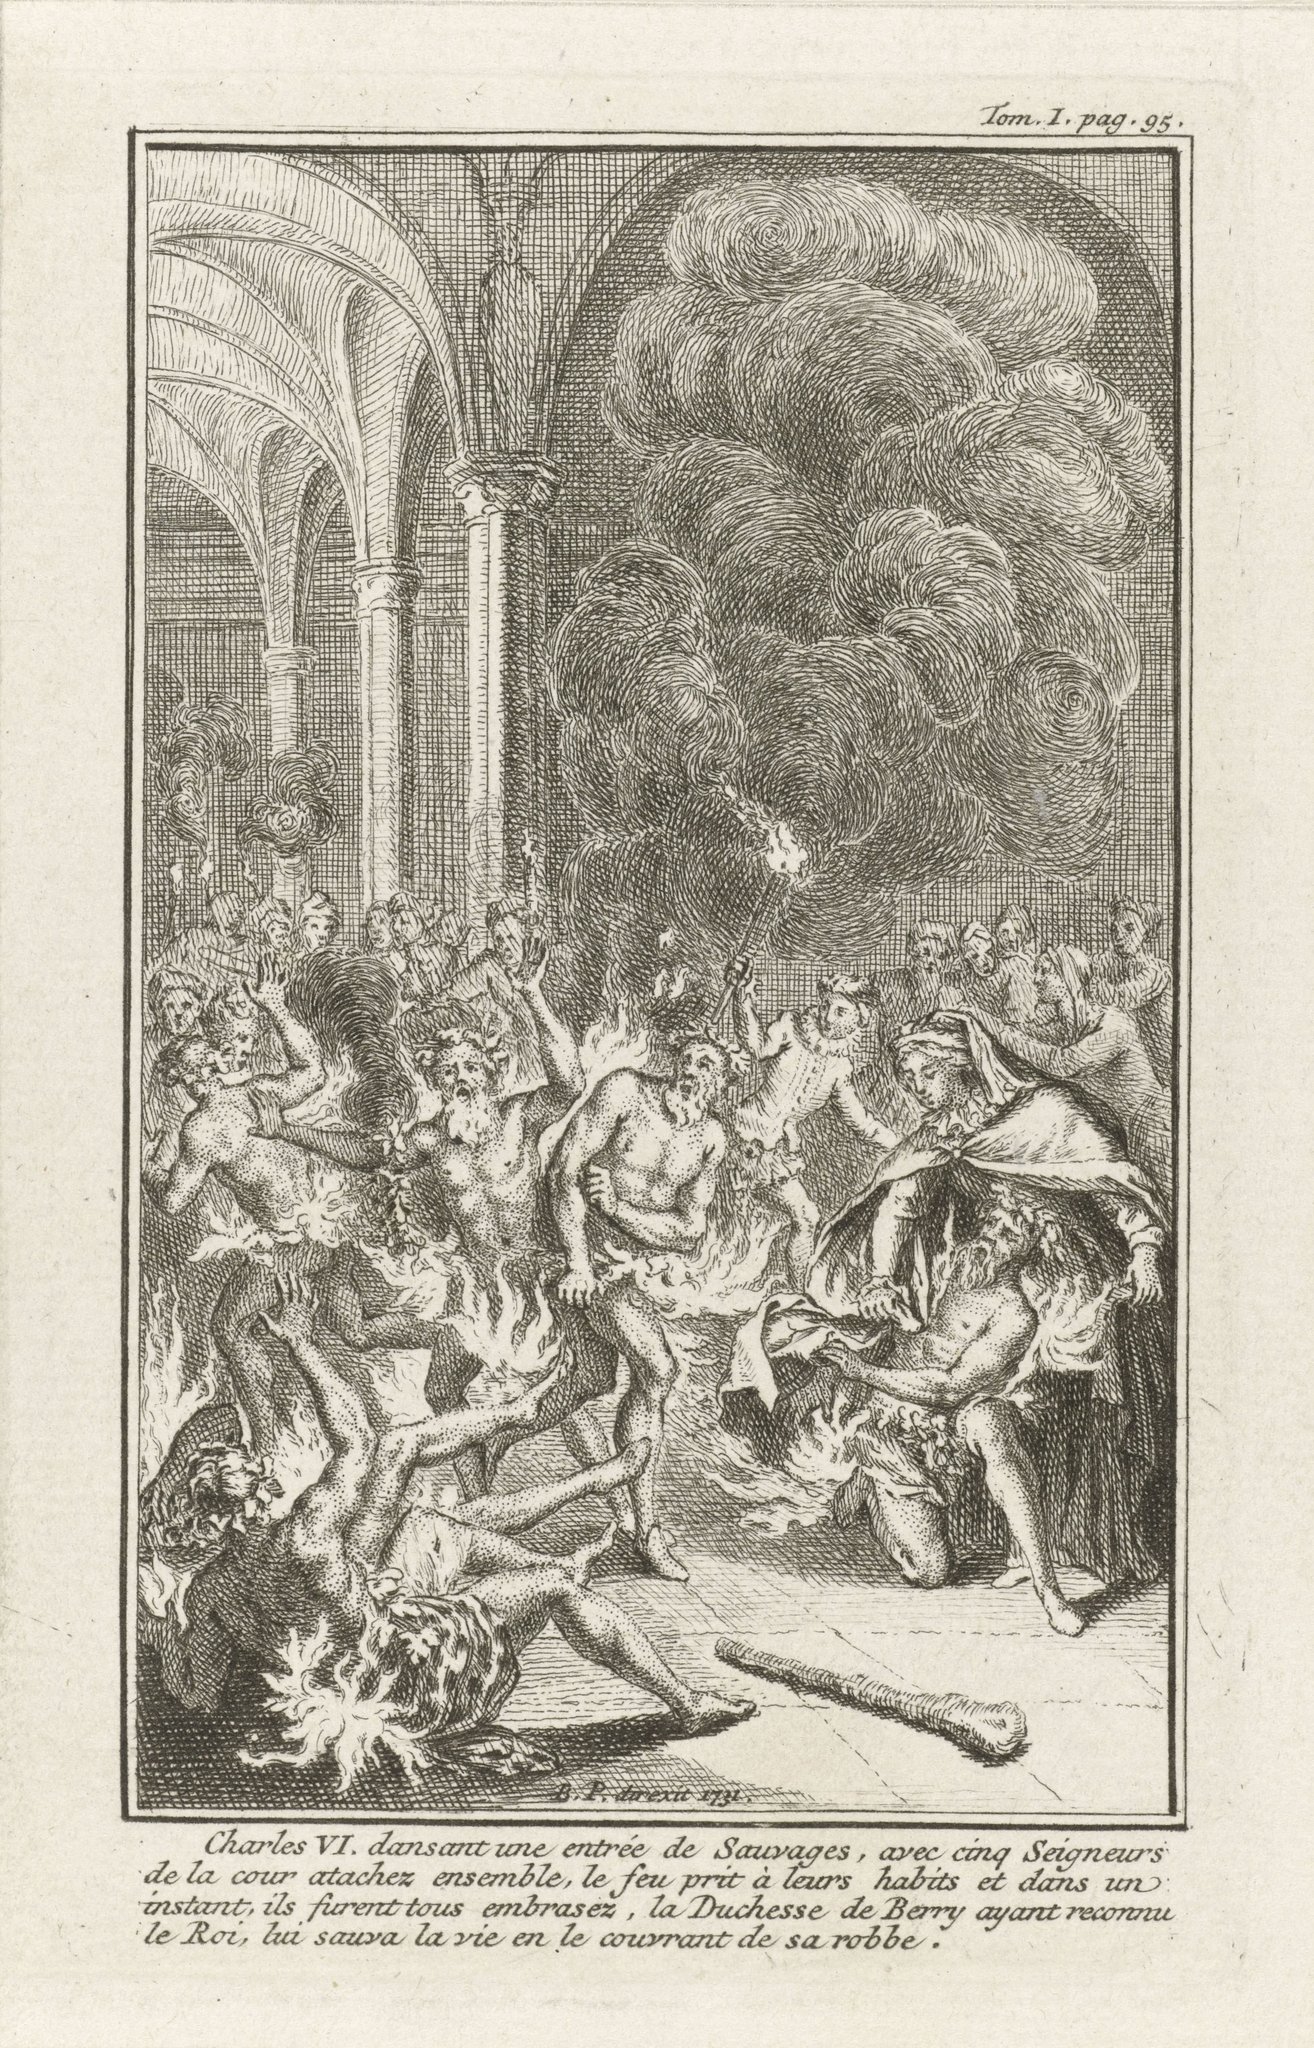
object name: print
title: Bal des Ardents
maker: bernard picart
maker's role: draughtsman, print maker, publisher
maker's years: 1673-1733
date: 1731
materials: paper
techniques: etching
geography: amsterdam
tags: paris, palace - aa - civic architecture: inside, wedding reception, rescue from fire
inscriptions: collector's mark: Lugt 240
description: Koning Karel VI en vijf andere mannen zijn verkleed als wilden en dansen op een huwelijksfeest. Een man met een brandende fakkel steekt een van hen in brand. De hertogin van Berry gooit haar mantel over de koning en redt zo diens leven. In de marge een vierregelig onderschrift in het Frans. Rechtsboven gemerkt: Tom. I, pag. 95.